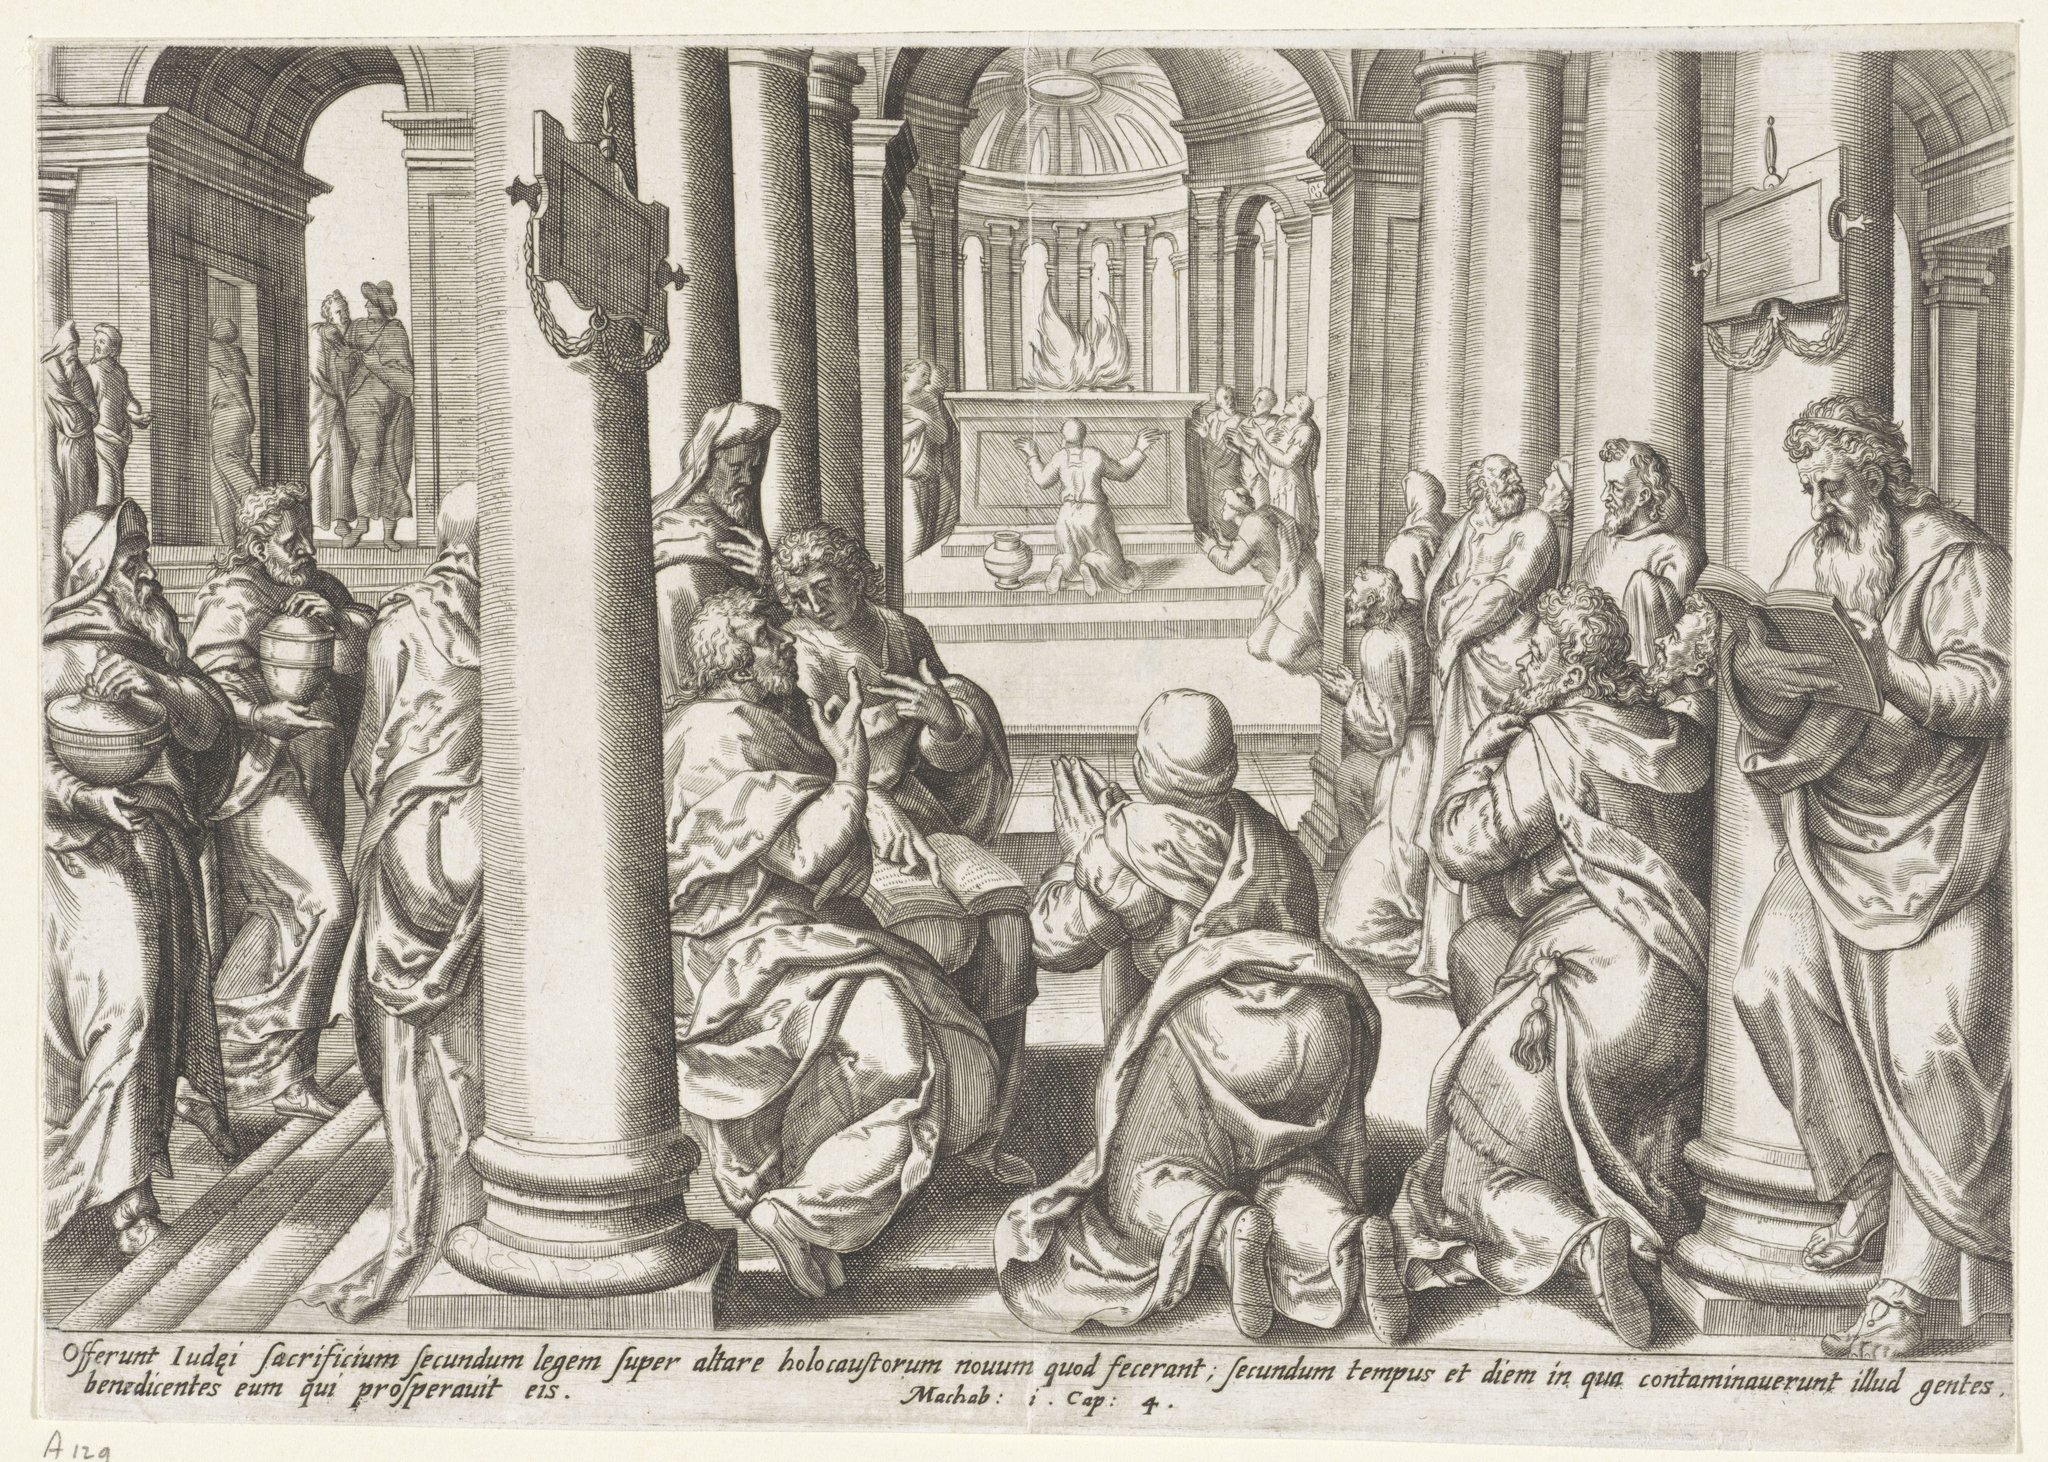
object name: print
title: Thesaurus sacrarum historiarum veteris testamenti (...)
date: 1572-1576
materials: paper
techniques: engraving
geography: antwerp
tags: judas maccabeus has the temple purified and re-dedicated (1 maccabees 4:36-58)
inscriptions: collector's mark: Lugt 2228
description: Het nieuwe altaar in de tempel van Jeruzalem wordt ingewijd, terwijl de Israëlieten zingen. Anderen brengen offers mee. Op het nieuwe altaar brandt een offer. Onder de voorstelling een verwijzing in het Latijn naar de Bijbeltekst in 1 Makk. 4.